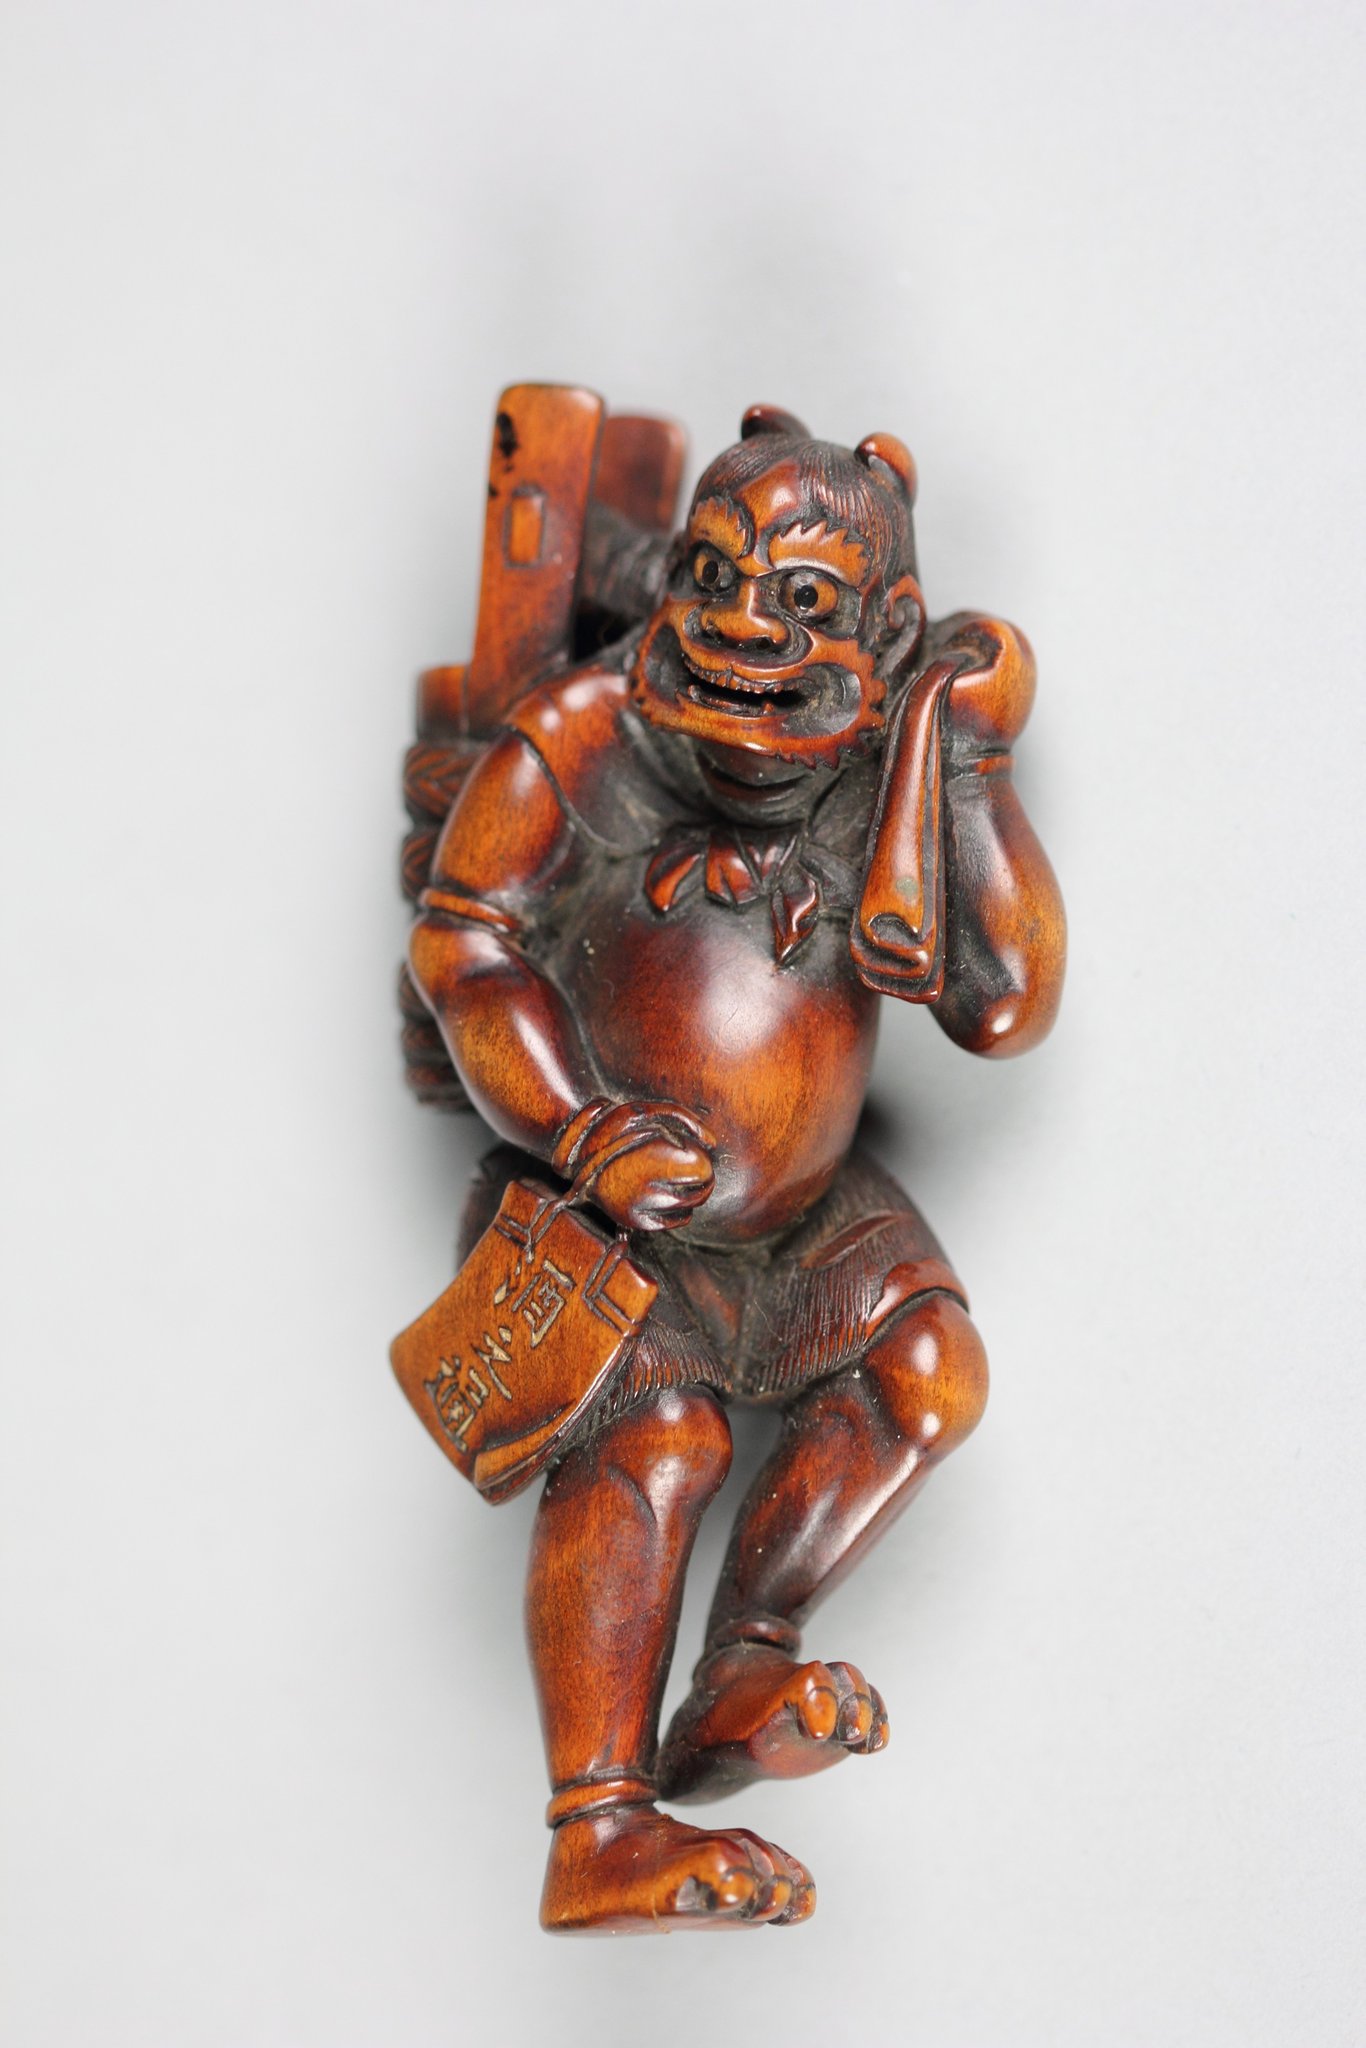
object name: netsuke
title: Netsuke of Demon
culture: japanese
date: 1801-1900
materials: wood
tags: demons